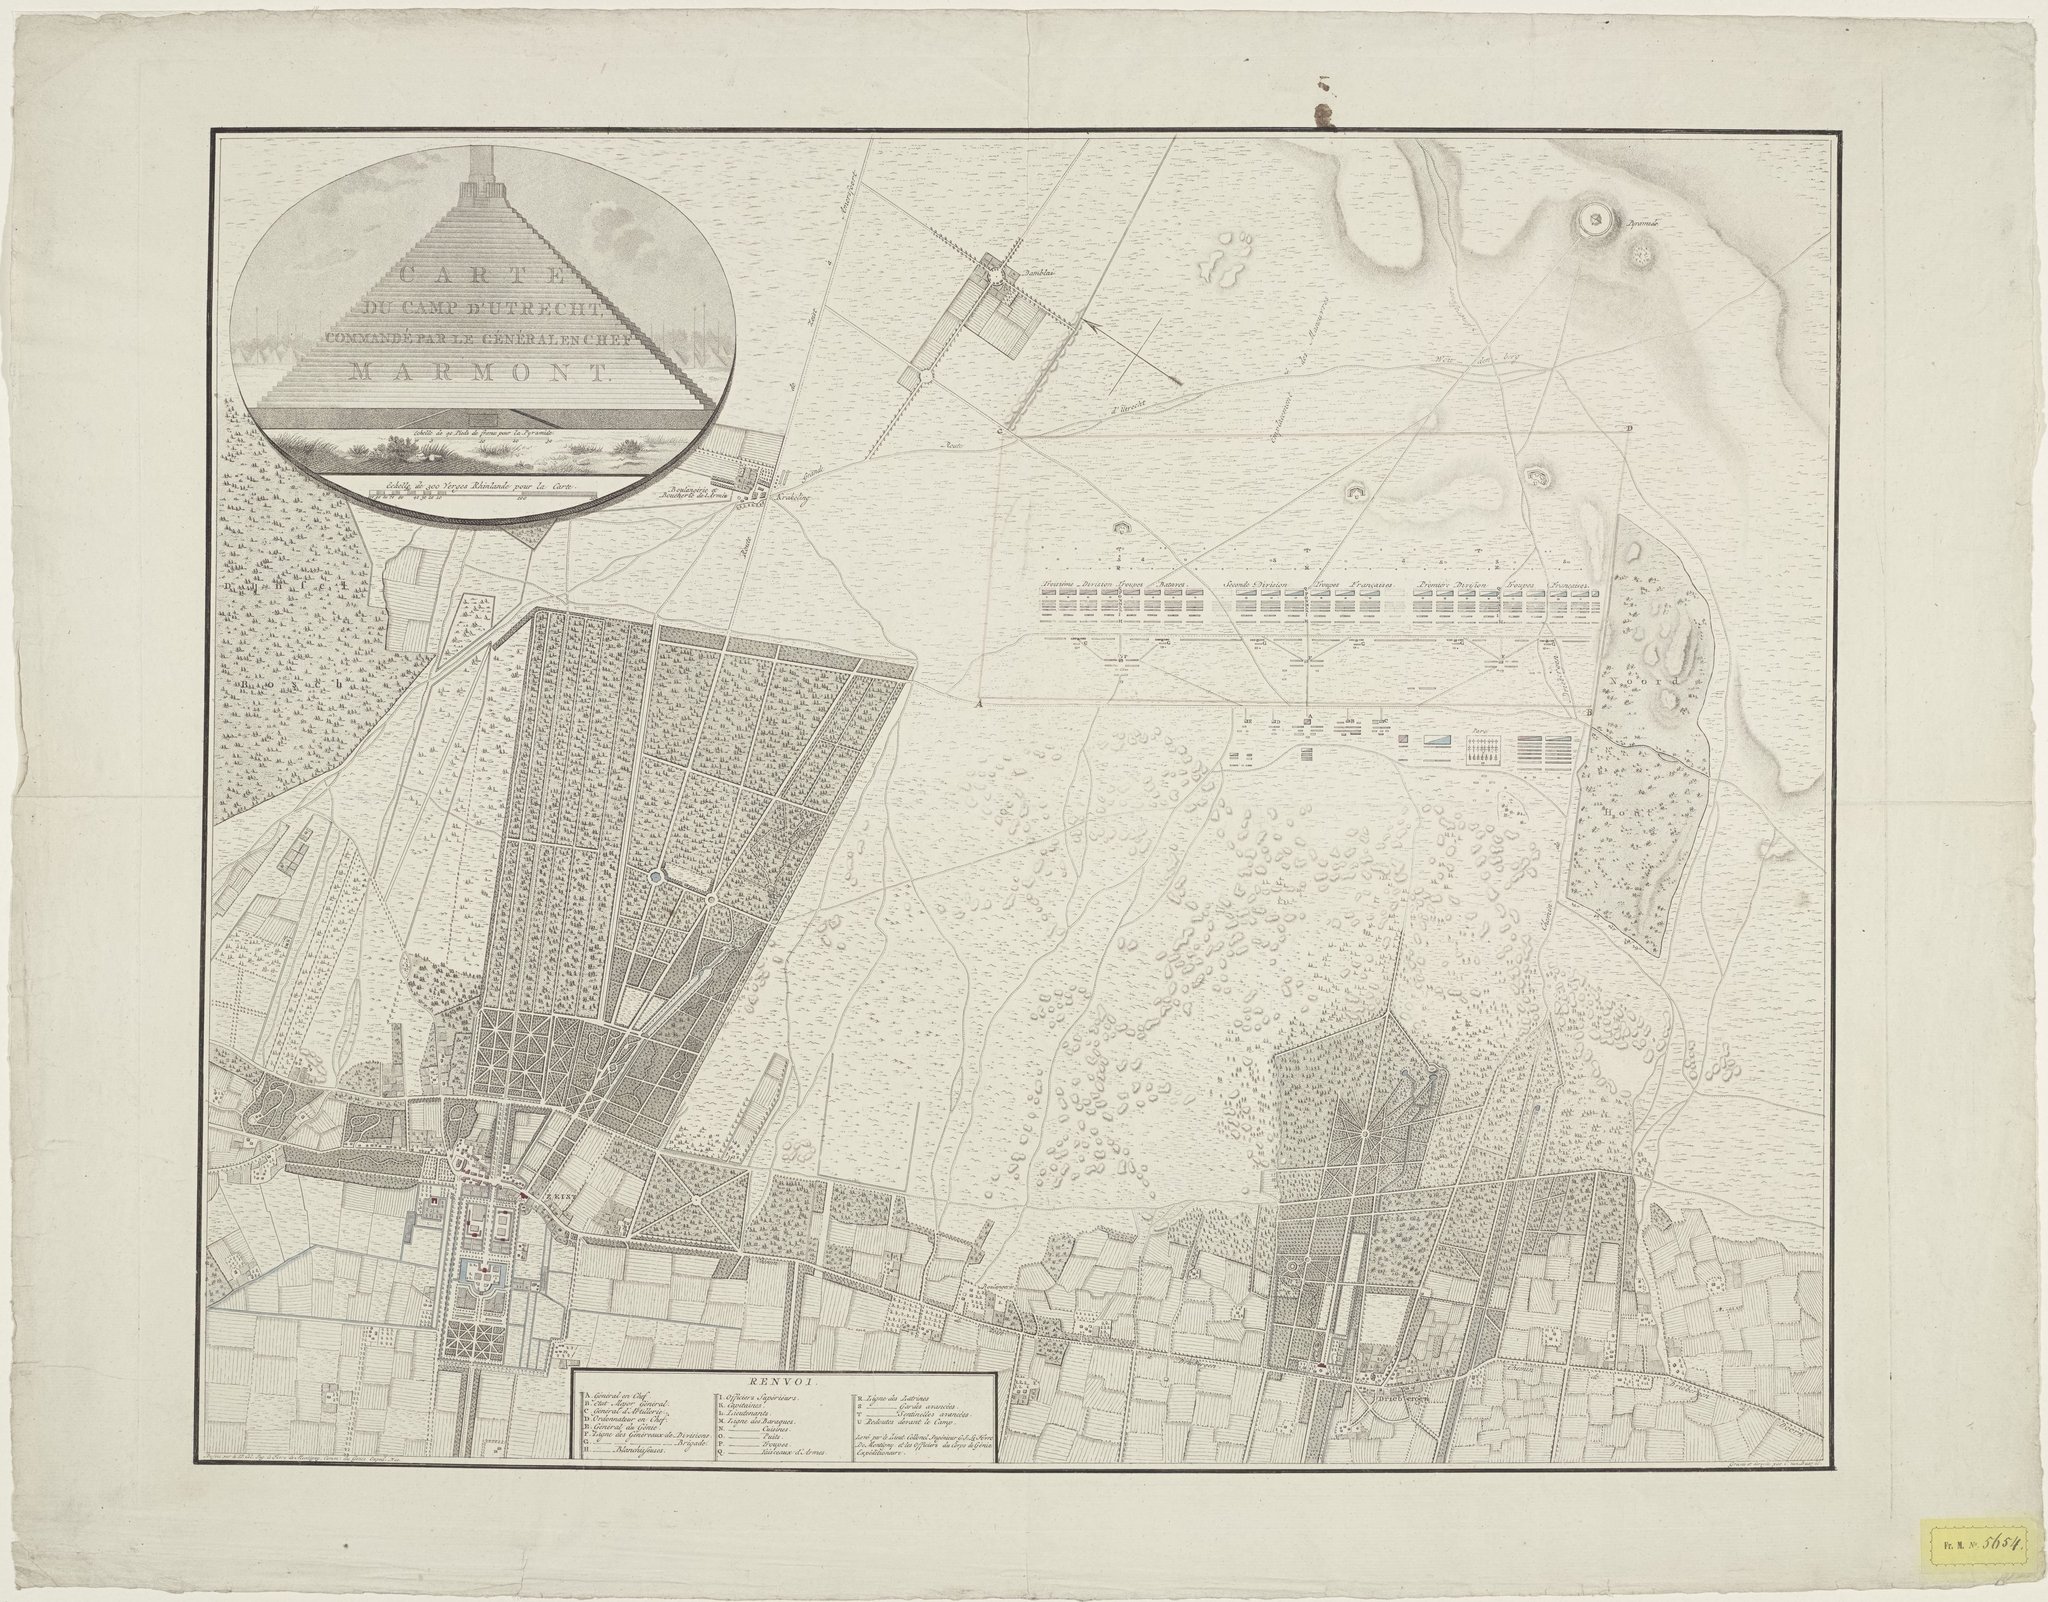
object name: print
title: Carte du camp d'Utrecht, commandé par le général en chef Marmont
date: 1805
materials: paper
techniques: etching, hand coloring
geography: netherlands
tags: maps of separate countries or regions, zeist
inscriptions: label: ‘Fr. M. No. 5654’, collector's mark: Lugt 2228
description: Kaart van het gebied tussen Zeist en Driebergen met het legerkamp van het Bataafse en Franse leger onder leiding van generaal Auguste de Marmont, 1804-1805. Linksboven een inzet met een gezicht op de pyramide van Austerlitz, opgetrokken in 1804 door de aldaar gelegerde soldaten.